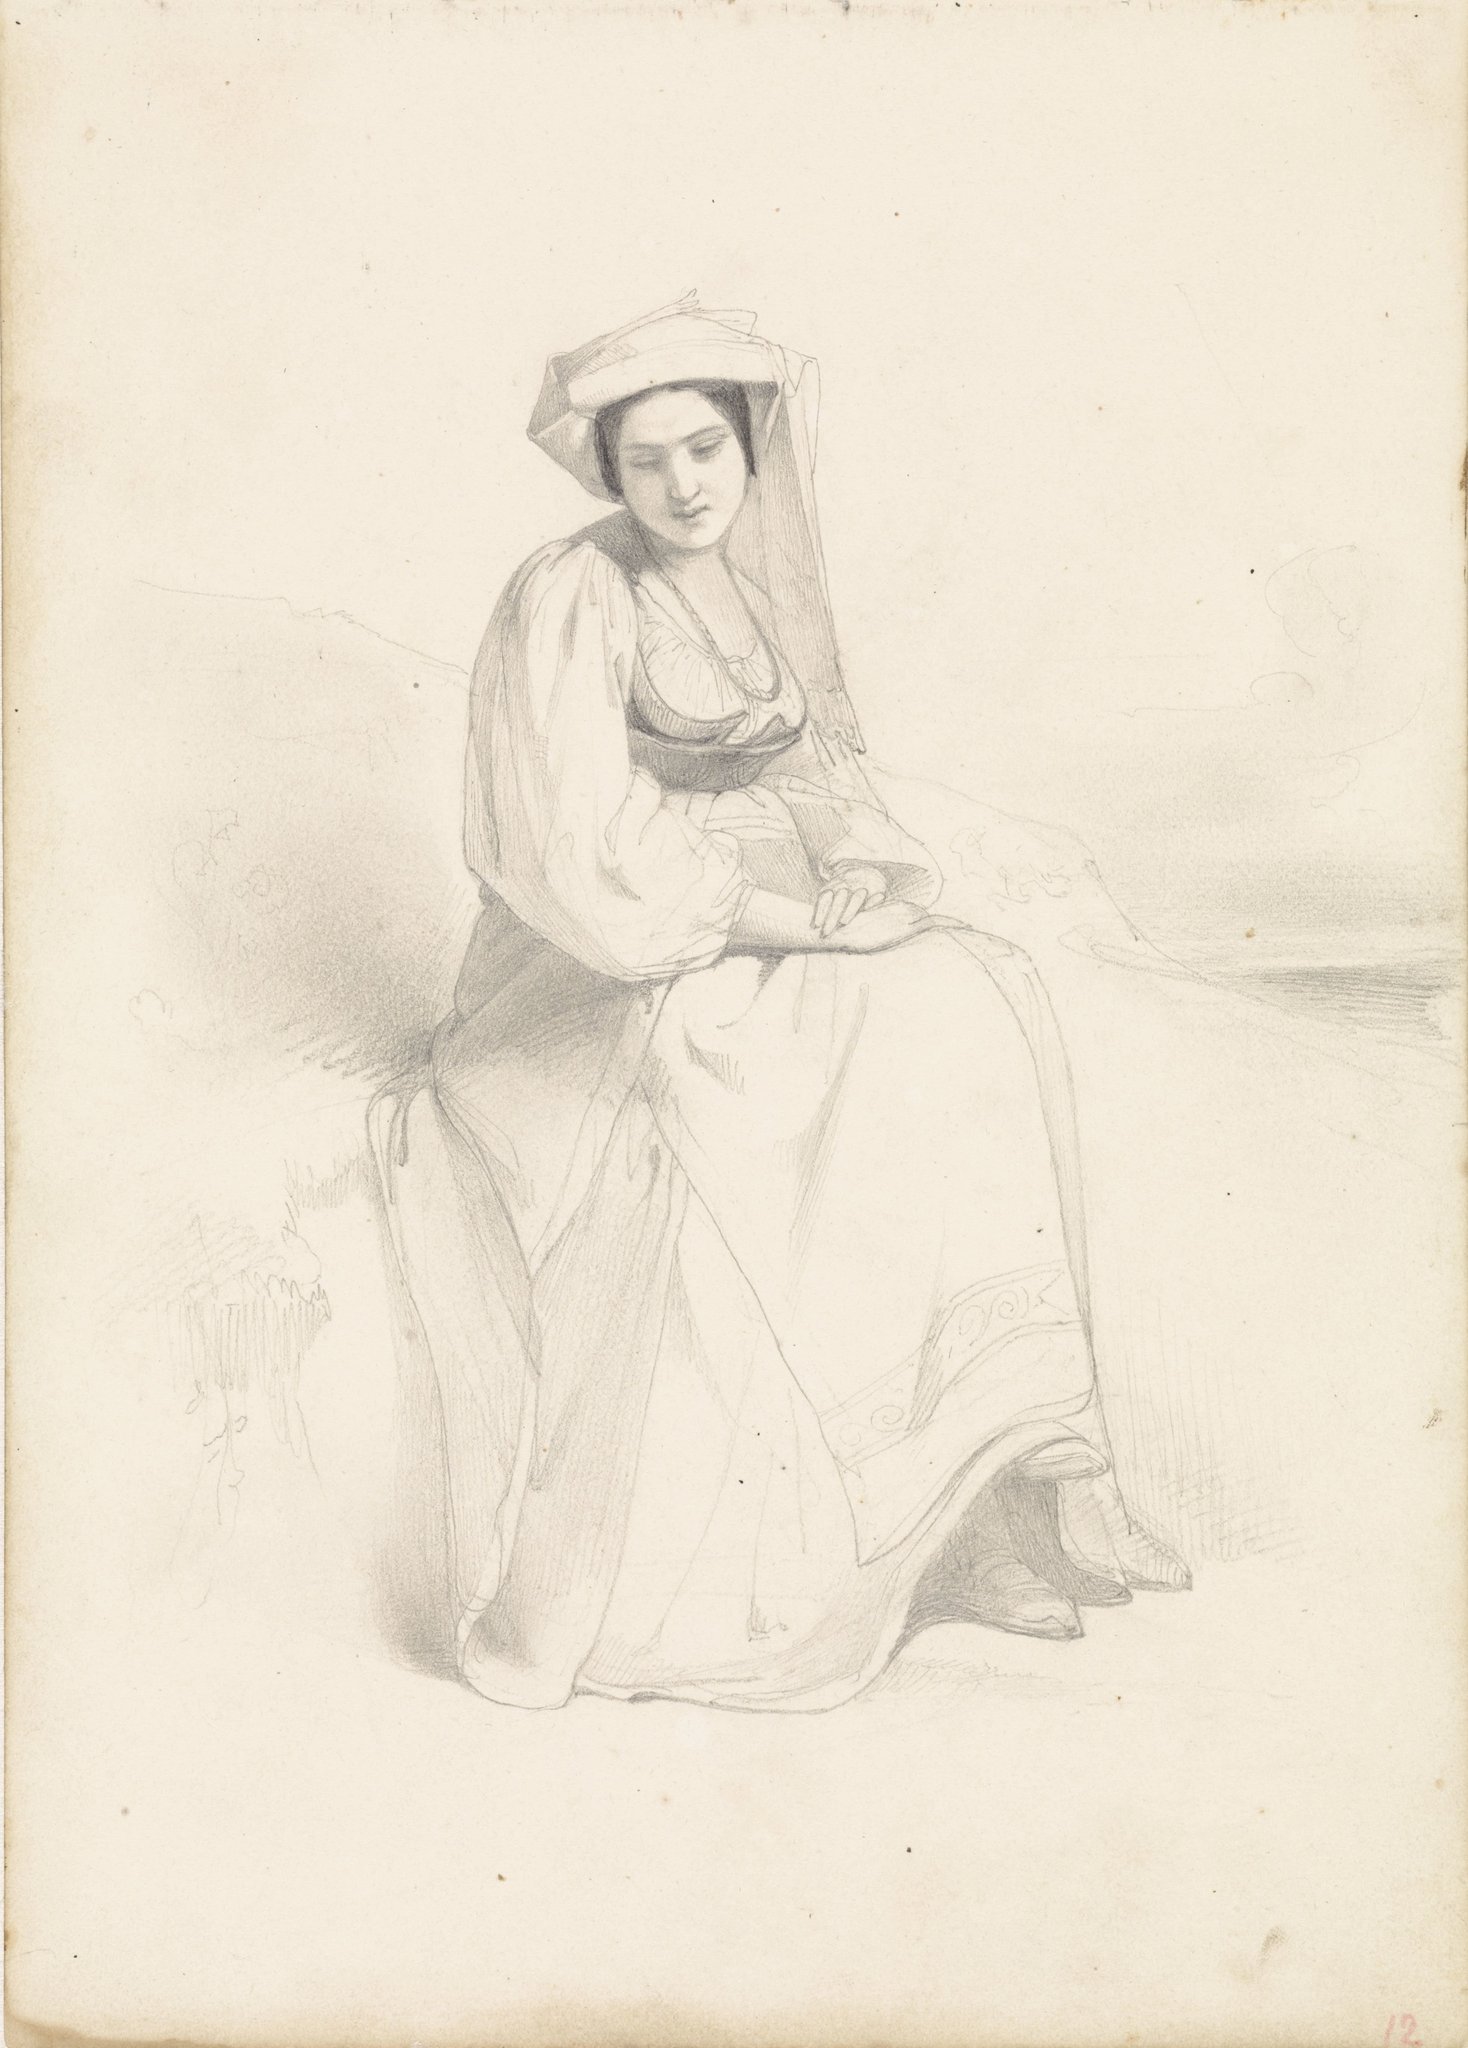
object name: drawing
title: Zittende vrouw aan een kust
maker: johan hendrik koelman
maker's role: draughtsman, print maker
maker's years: 1820-1887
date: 1830-1887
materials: paper, pencil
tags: folk costume, regional costume, italy